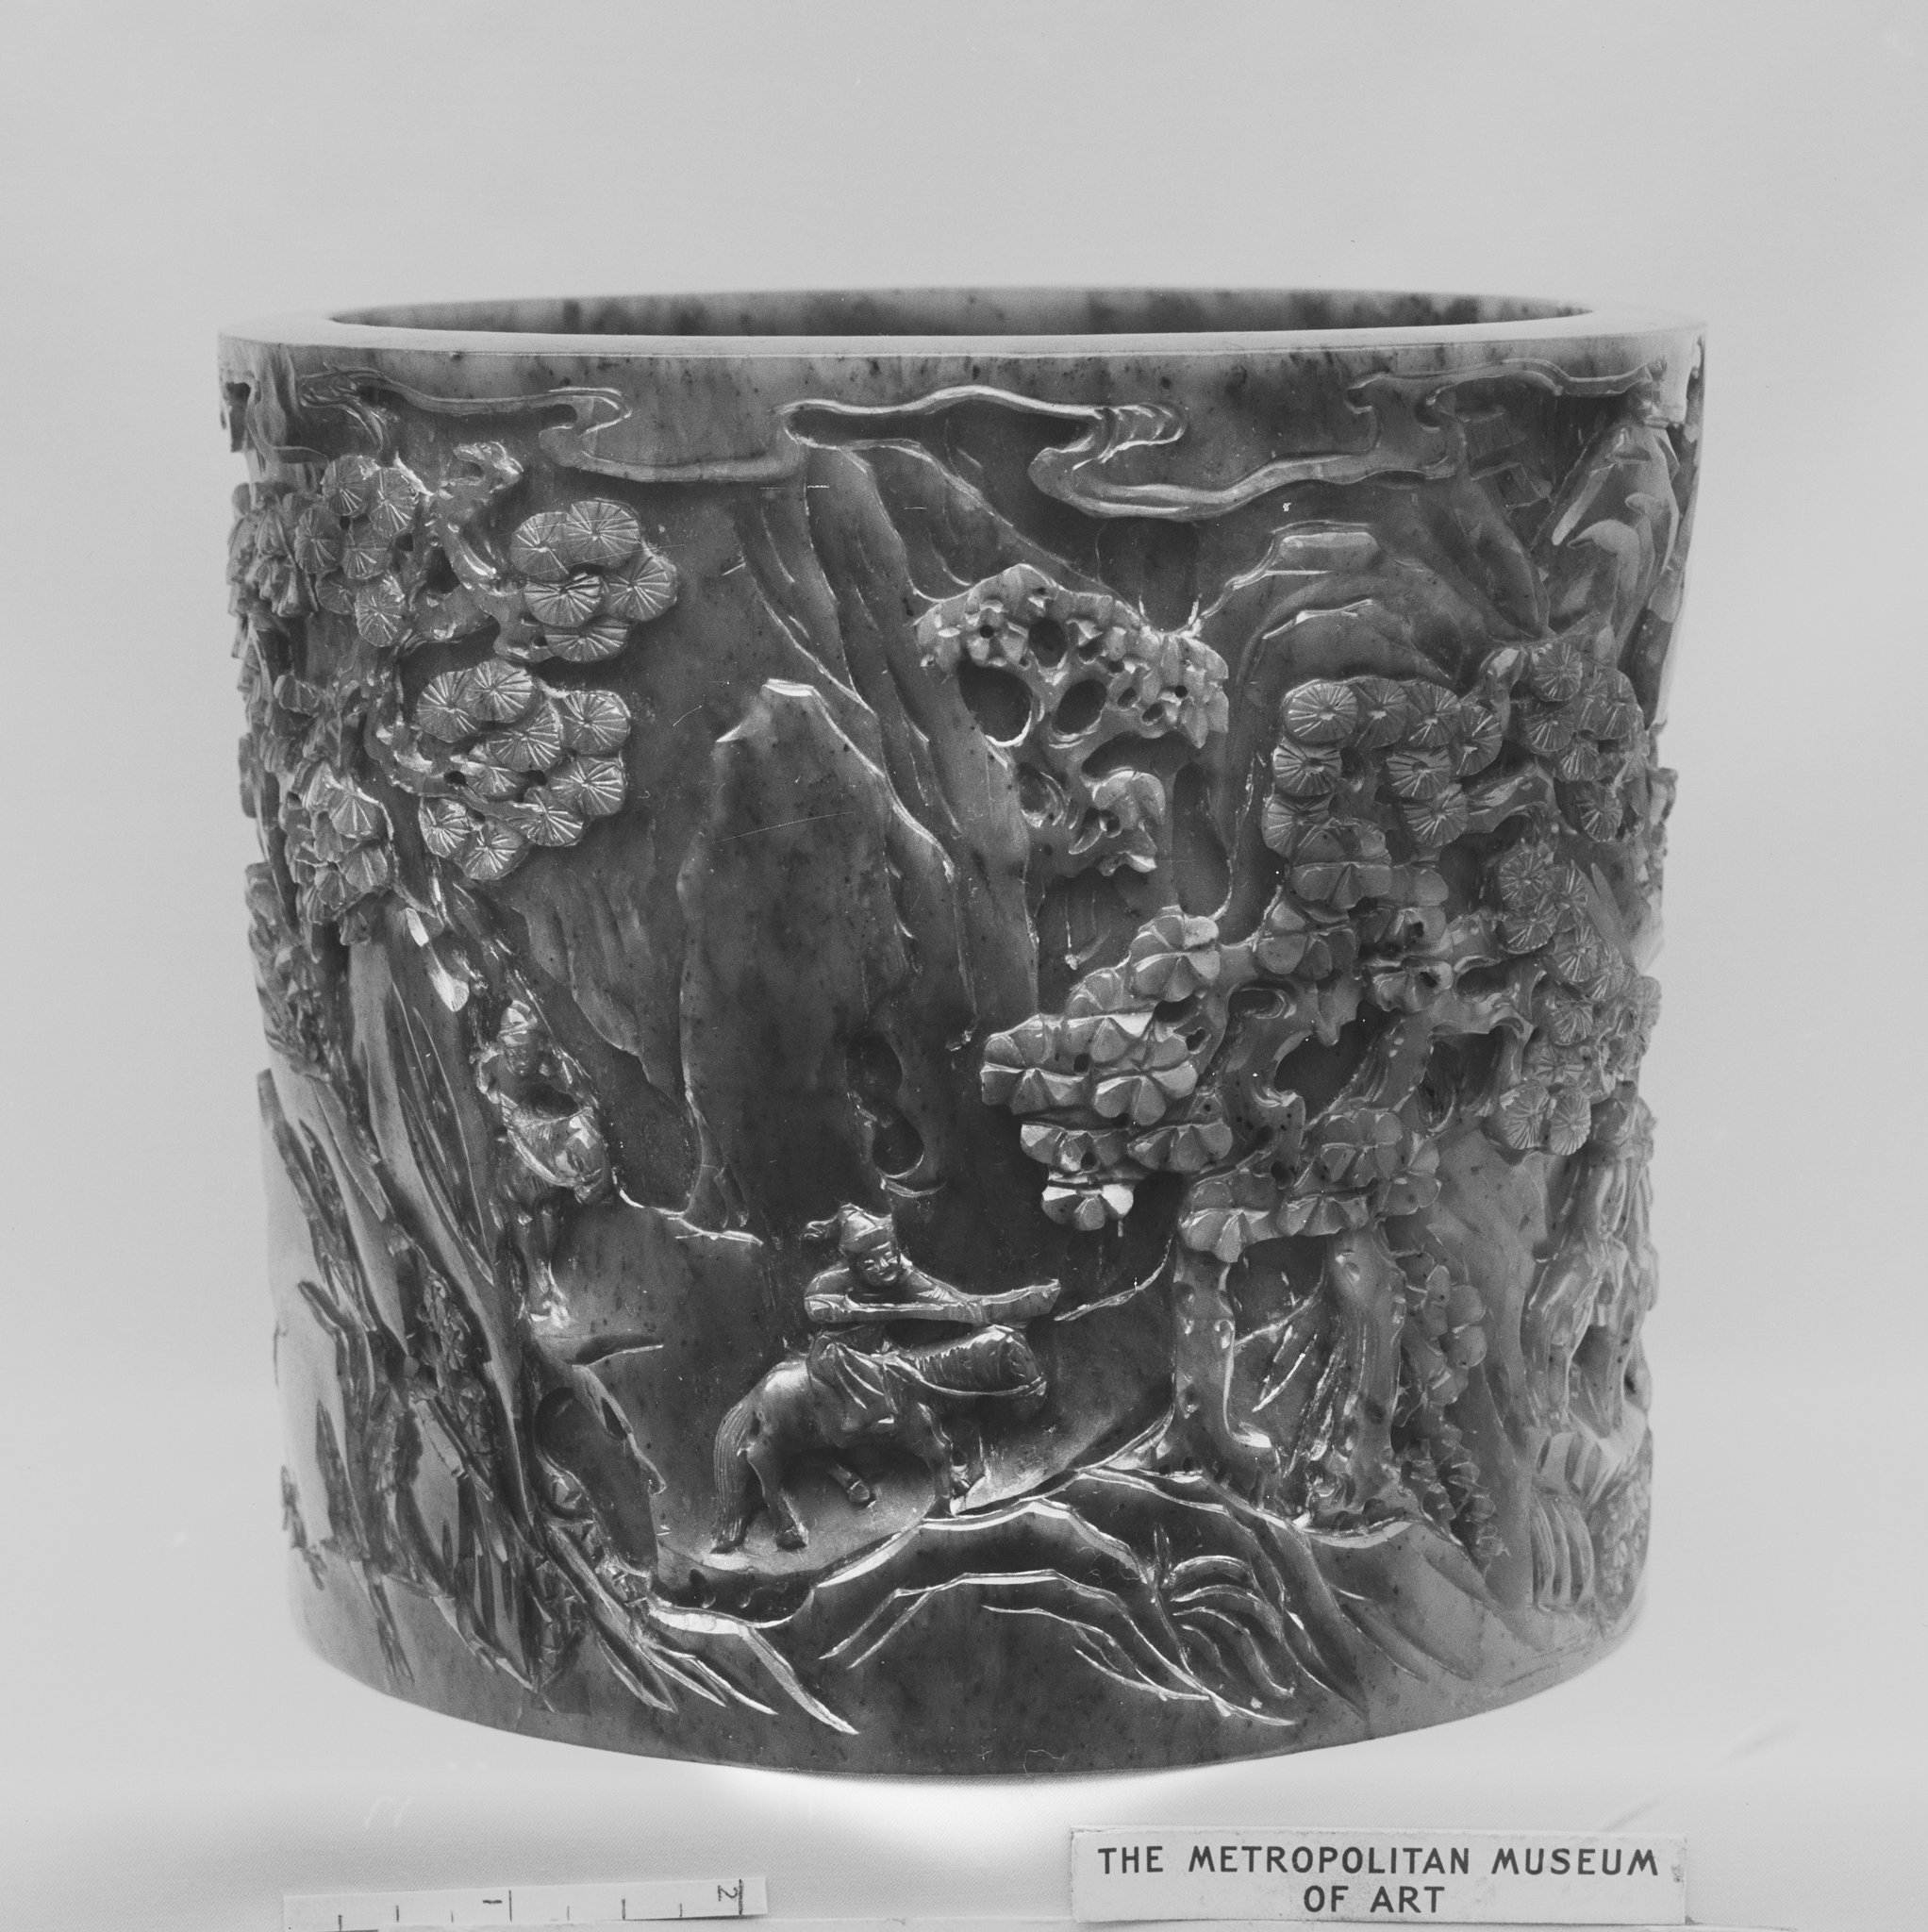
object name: brush holder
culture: chinese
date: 1701-1800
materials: jade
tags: horses,trees